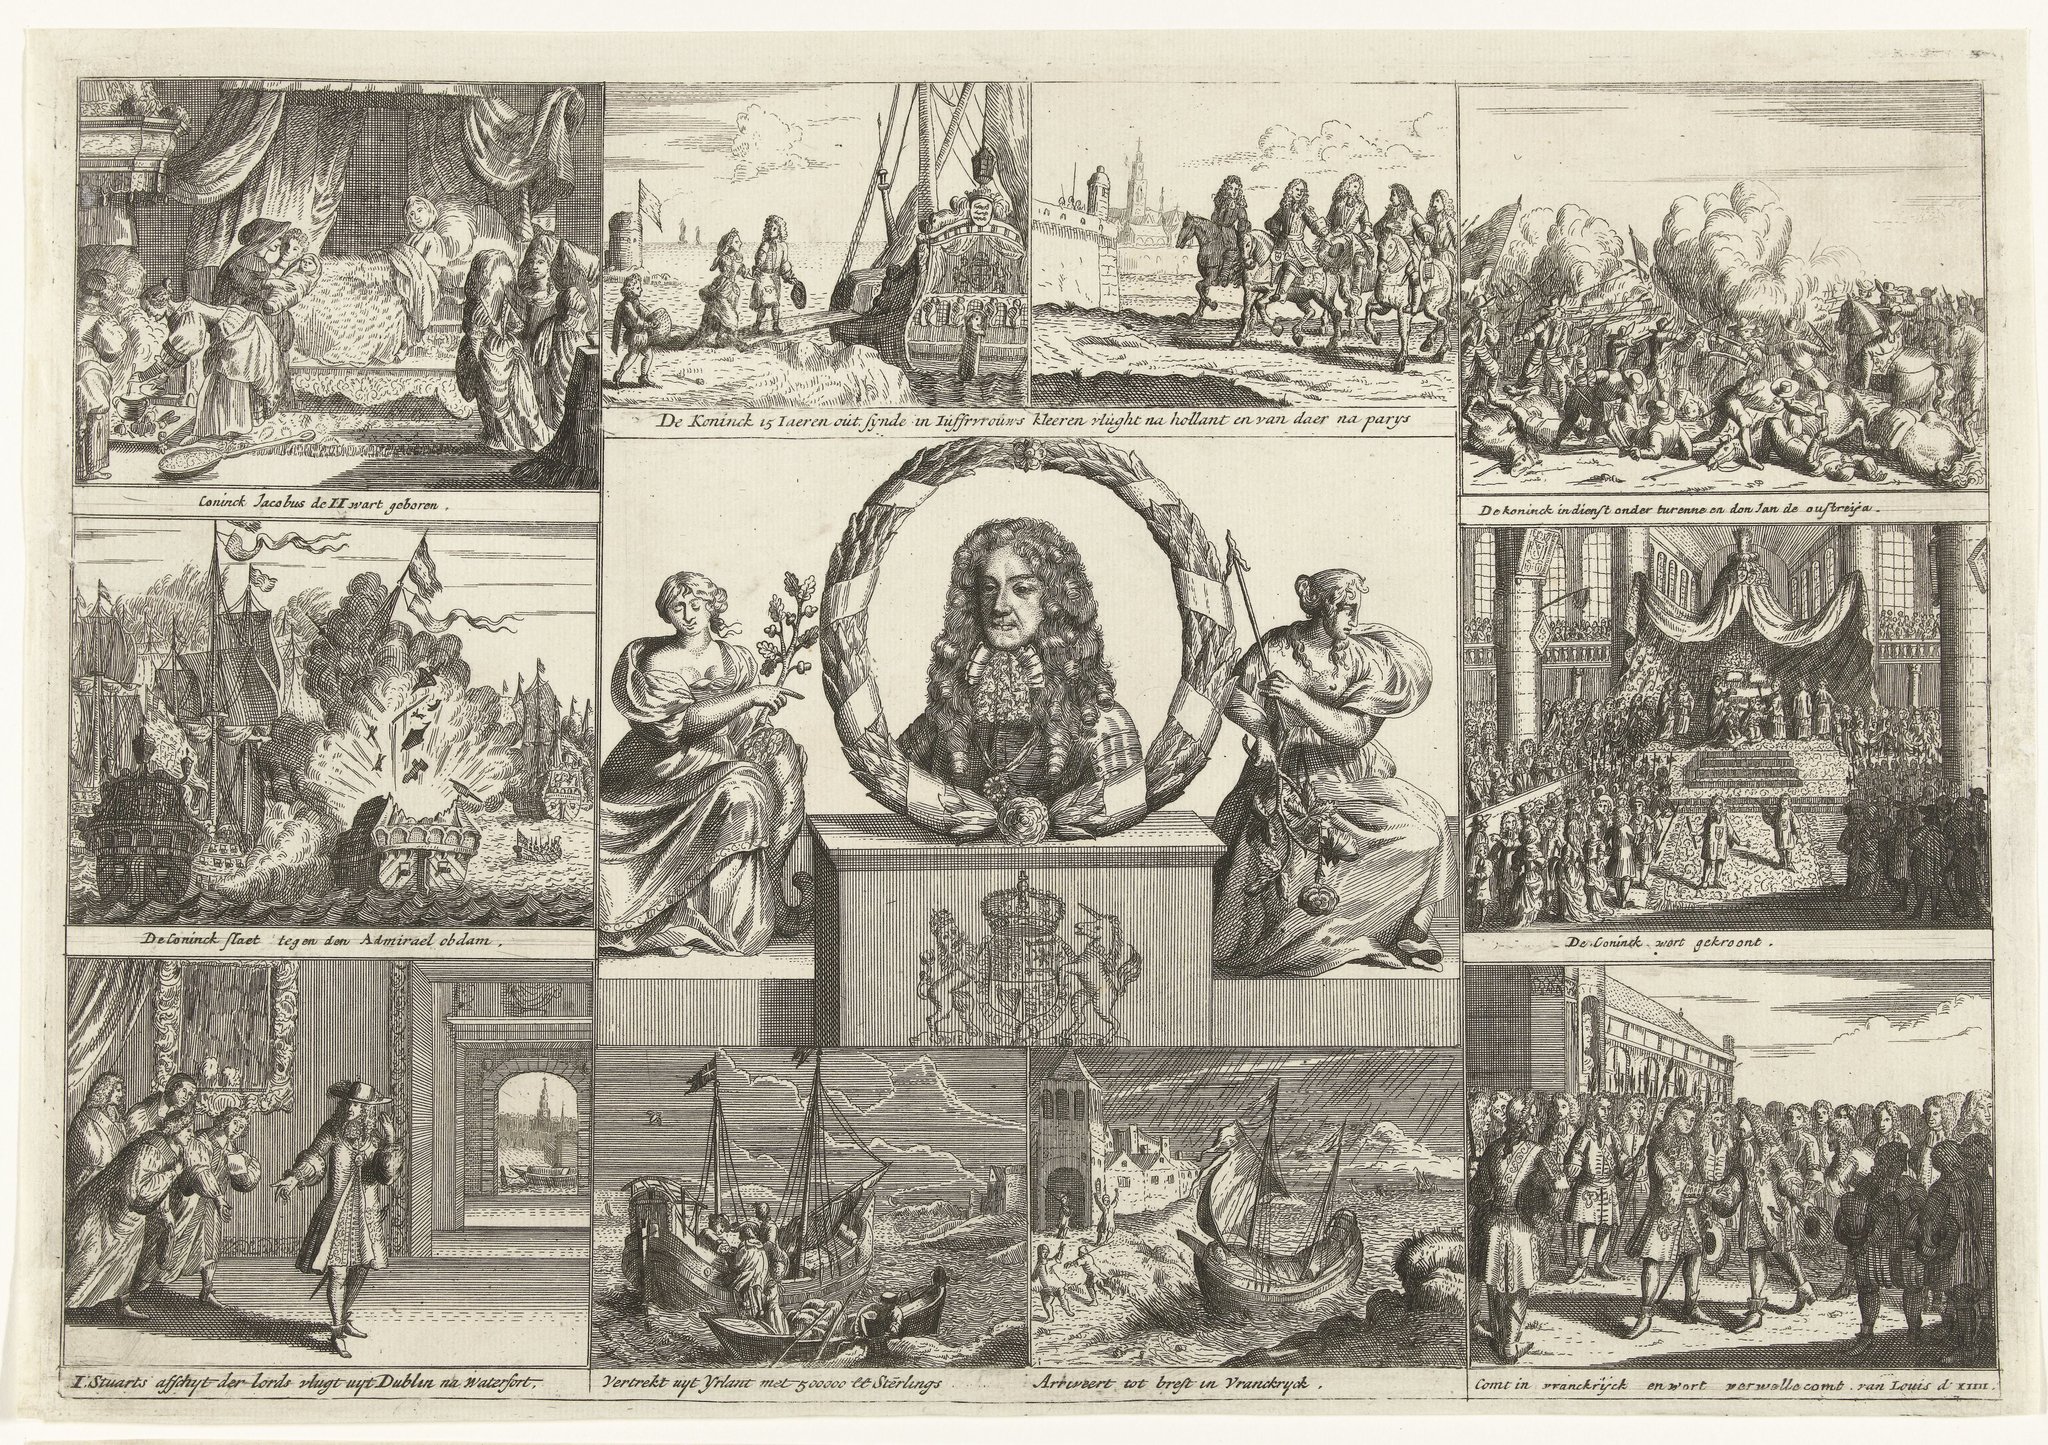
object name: print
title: Leven en bedrijf van koning Jacobus II van Engeland, 1690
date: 1690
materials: paper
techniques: etching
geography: northern netherlands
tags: jacobus ii (koning van engeland en schotland), deathbed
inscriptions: date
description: Leven en bedrijf van koning Jacobus II van Engeland, 1690. Blad met centraal een buste van Jacobus II in lauwerkrans vastgehouden door twee allegorische vrouwenfiguren. Hieromheen tien kleinere scènes uit het leven van de koning vanaf zijn geboorte in 1633 tot zijn vlucht naar Frankrijk in 1689. Bij de prent behoort een tekstblad.